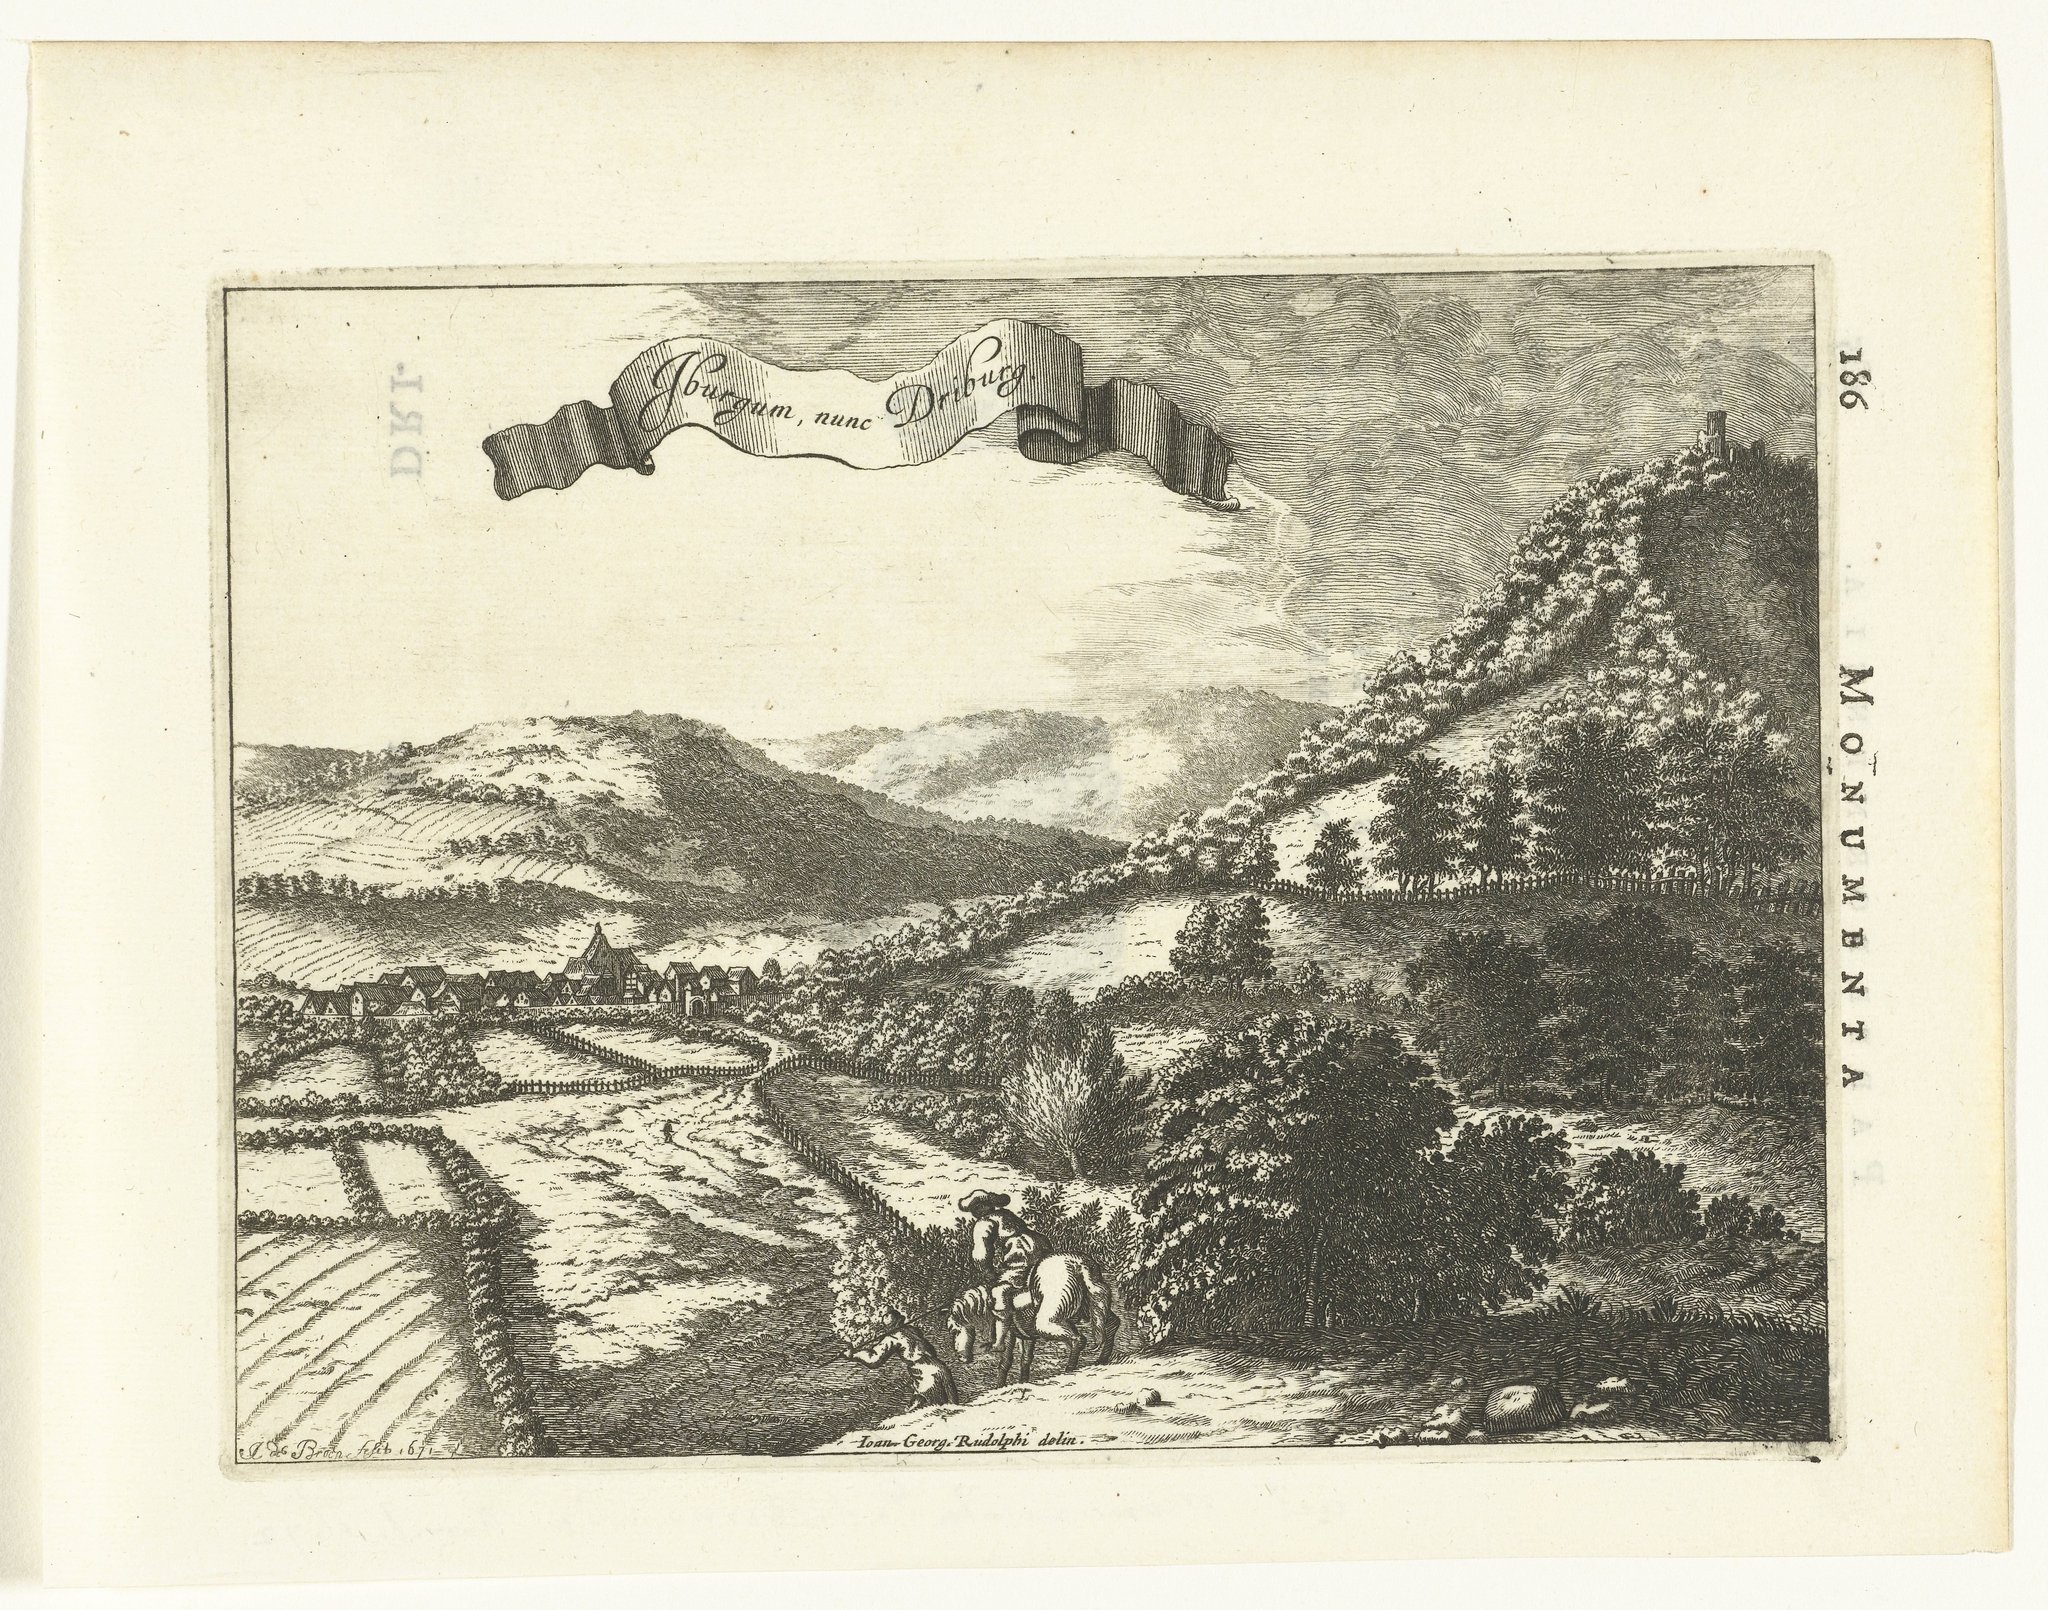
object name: print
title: Gezicht op Iburg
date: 1671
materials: paper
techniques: etching, letterpress printing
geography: amsterdam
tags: (high) hill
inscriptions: collector's mark: Lugt 2228, collector's mark: Lugt 2760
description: afkomstig uit: Ferdinand von Fürstenberg, Monumenta Paderbornensia, ex historia Romana, Francica, Saxonica eruta. Amsterdam, bij D. Elzevier, 1672 (of latere editie uit 1713).